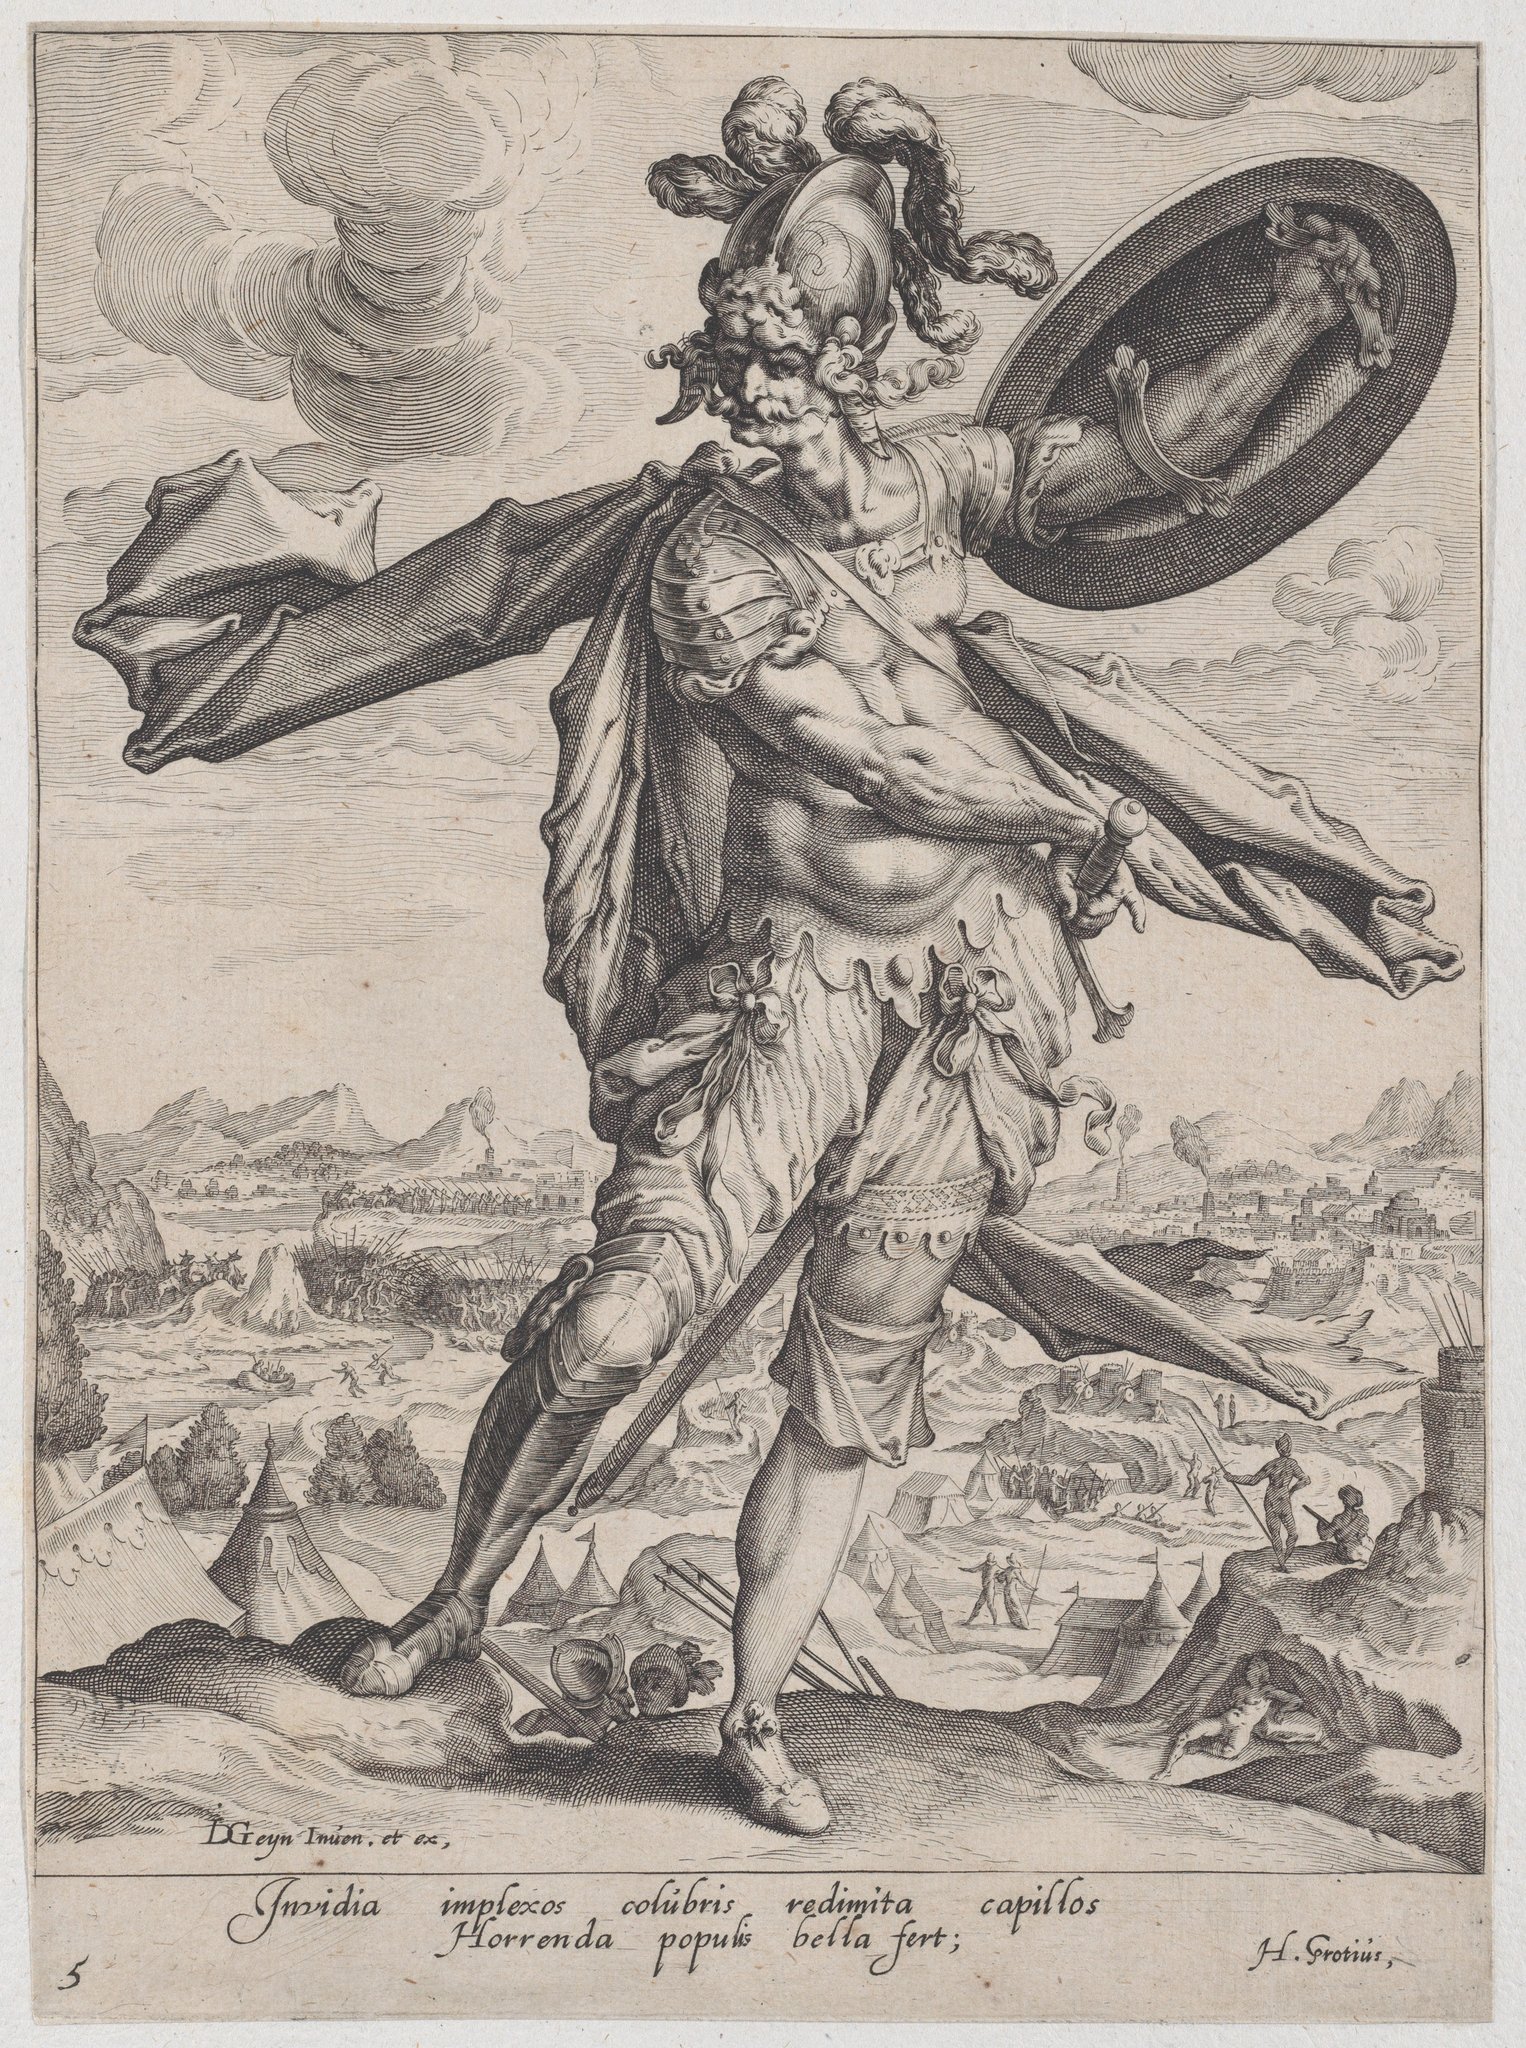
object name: print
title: War, from "Virtues and Vices"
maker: zacharias dolendo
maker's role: artist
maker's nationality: netherlandish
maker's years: 1561-1604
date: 1596-1597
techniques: engraving